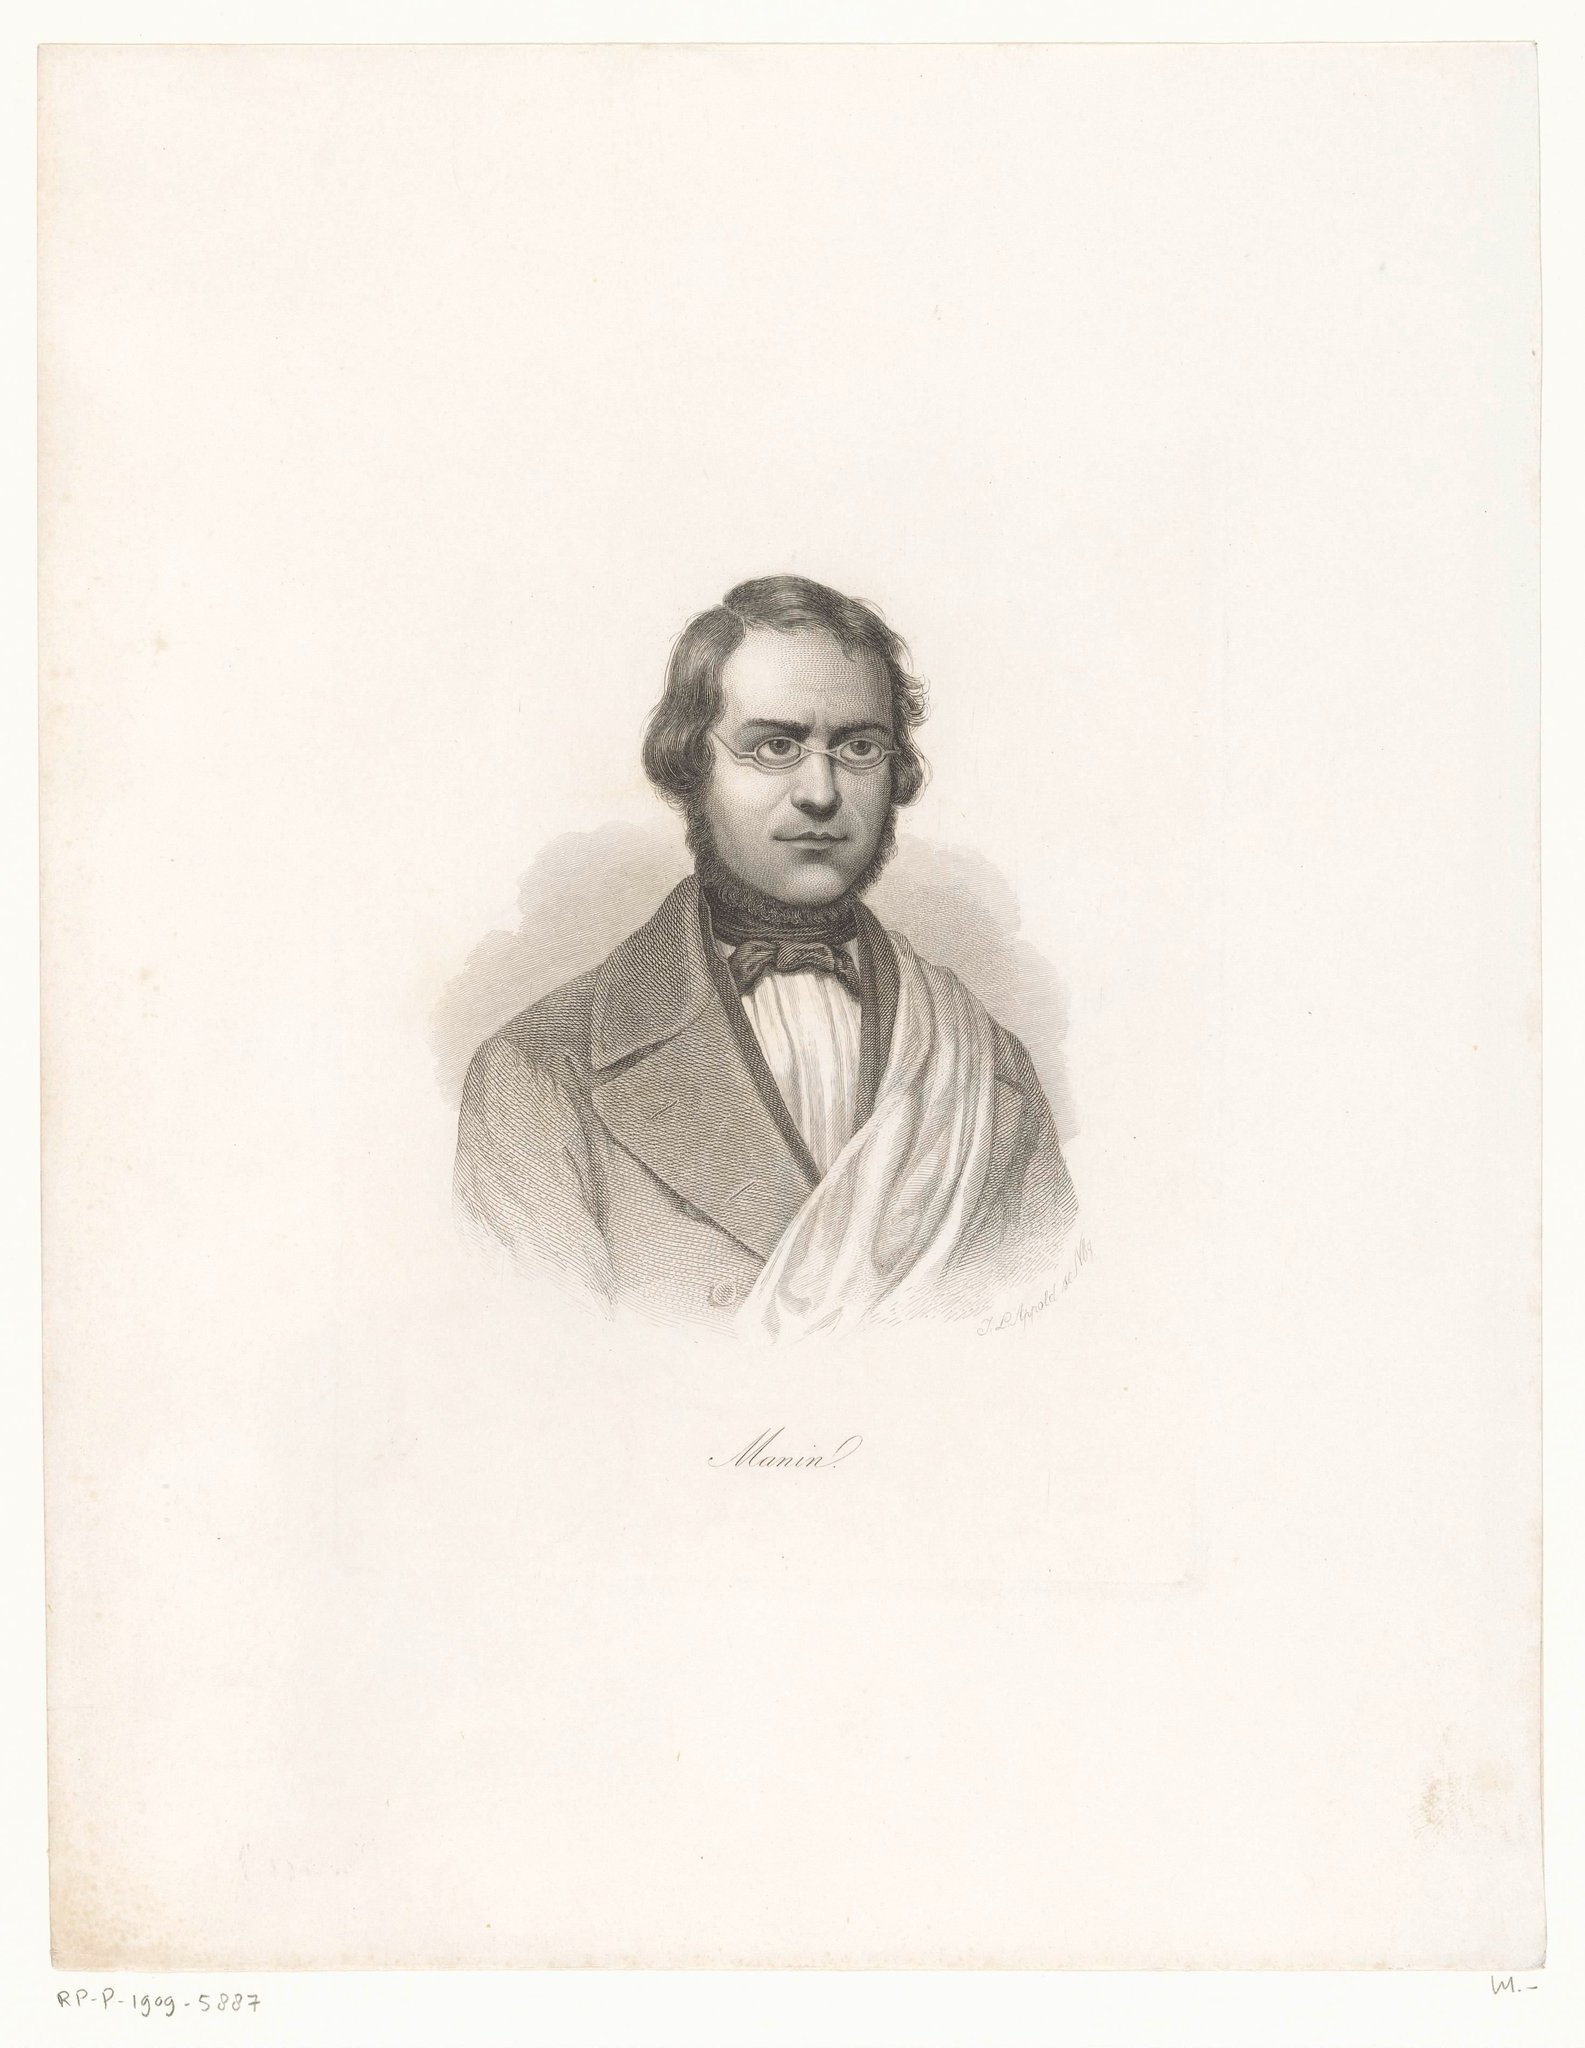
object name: print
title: Portret van Daniele Manin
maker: johann leonhard appold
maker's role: print maker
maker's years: 1809-1858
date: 1819-1858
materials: paper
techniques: etching, engraving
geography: nuremberg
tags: politician, historical persons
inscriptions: collector's mark: Lugt 2228